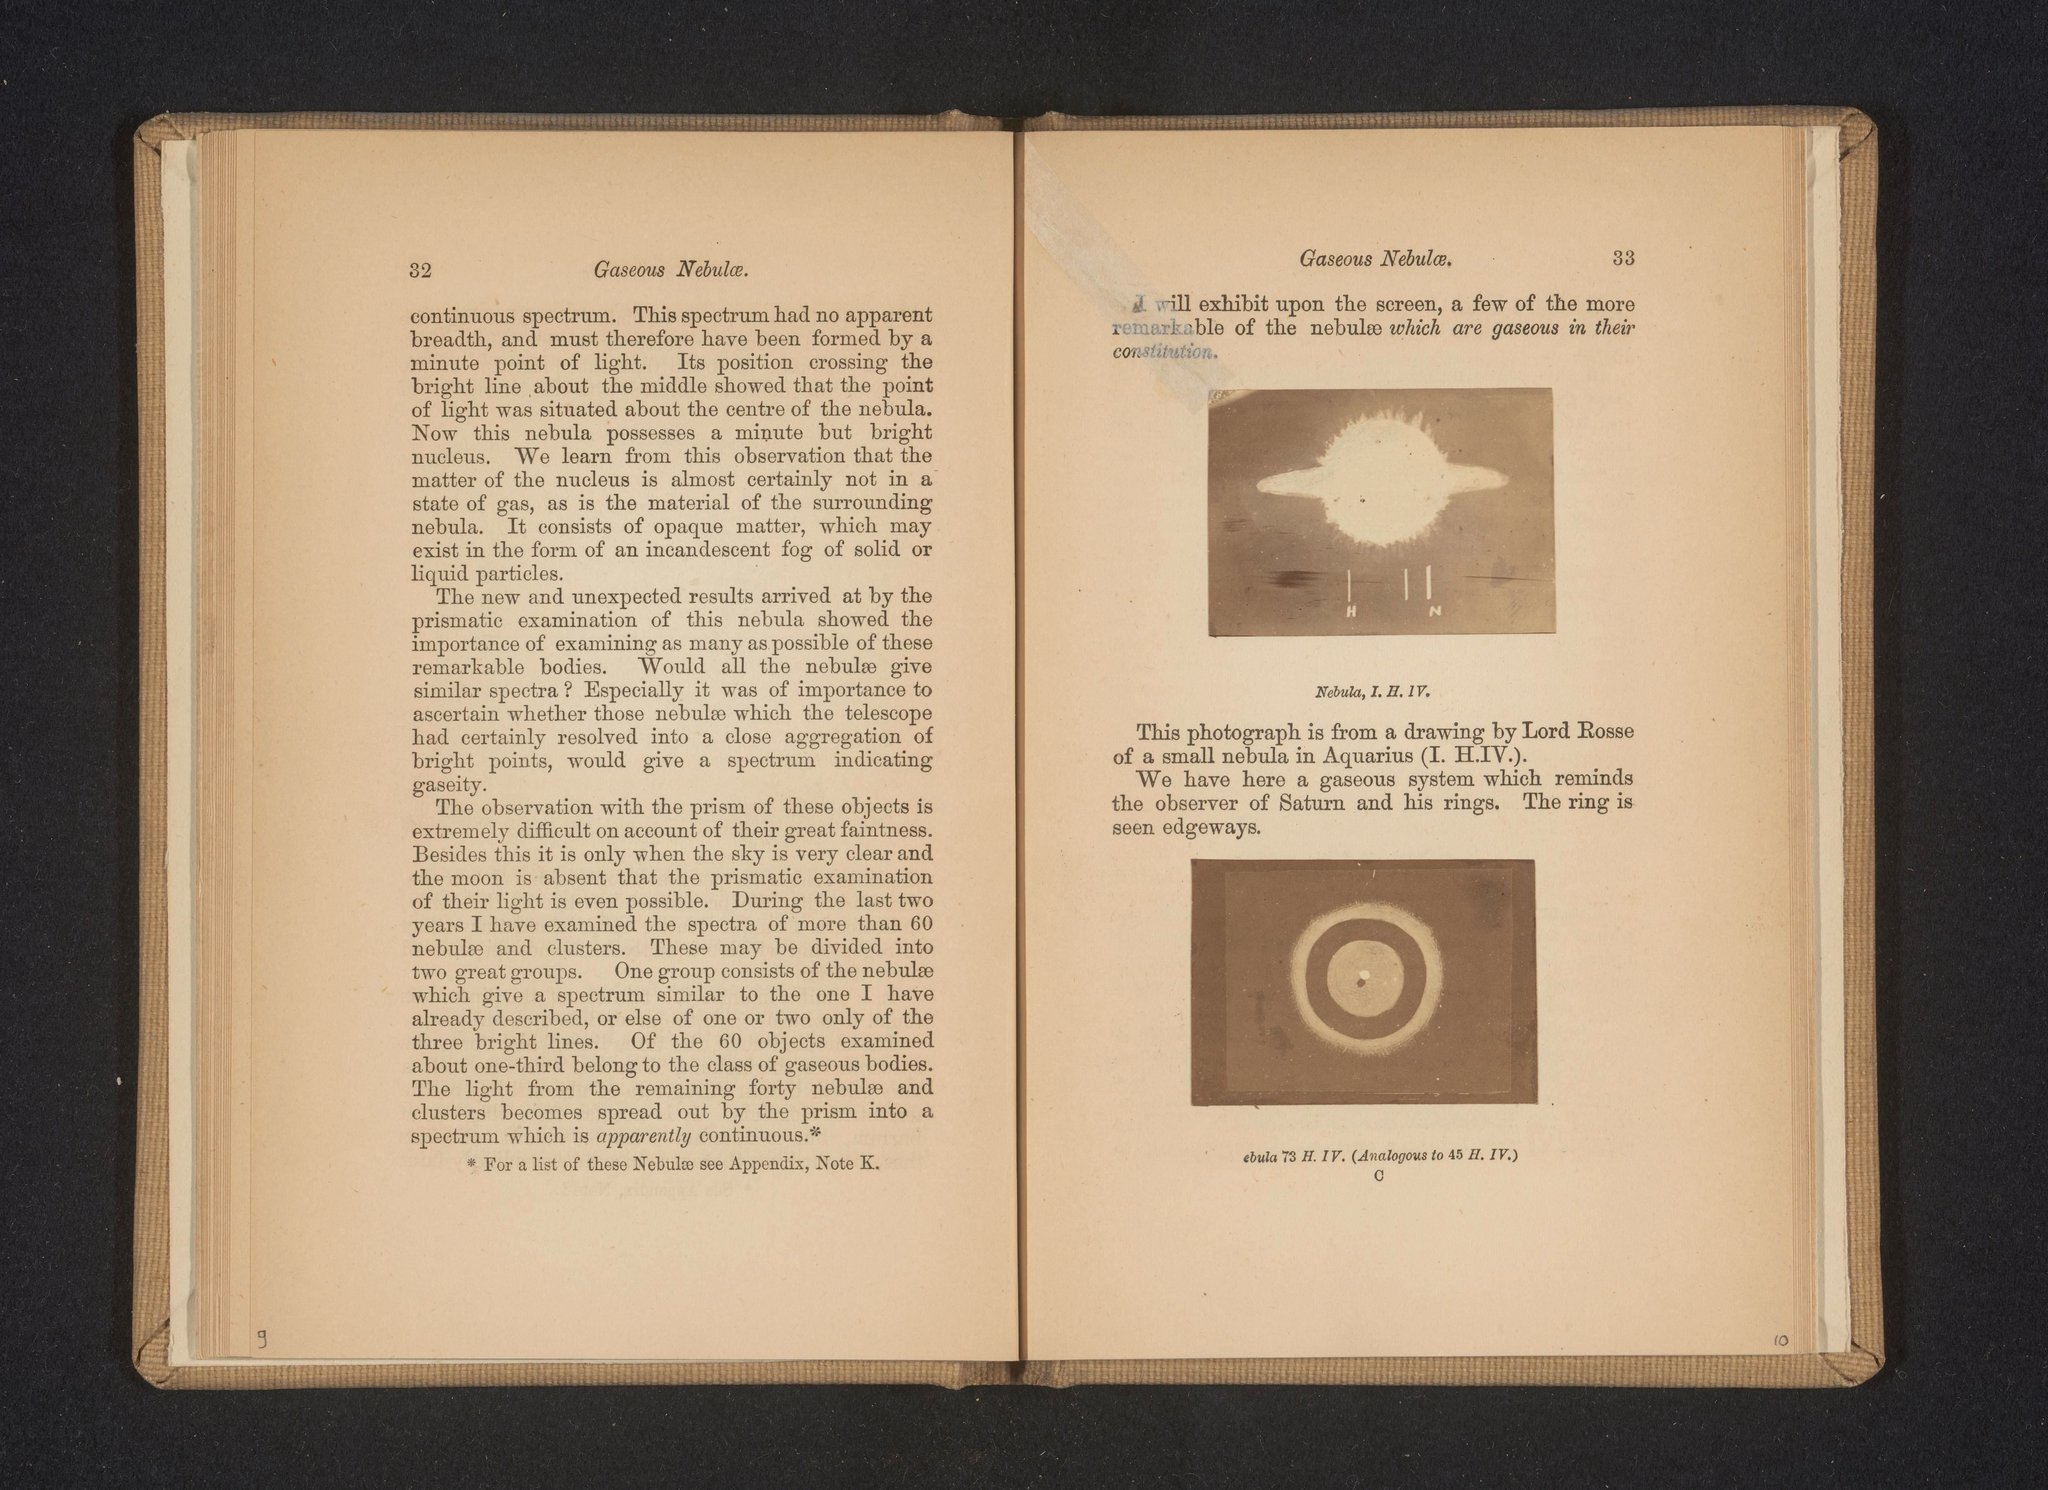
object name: photograph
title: Nebula, I. H. 1V. ebula 73 H. IV. (Analogous to 45 H. IV)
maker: Anonymous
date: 1856-1866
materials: photographic support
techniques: albumen print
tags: stars and constellations